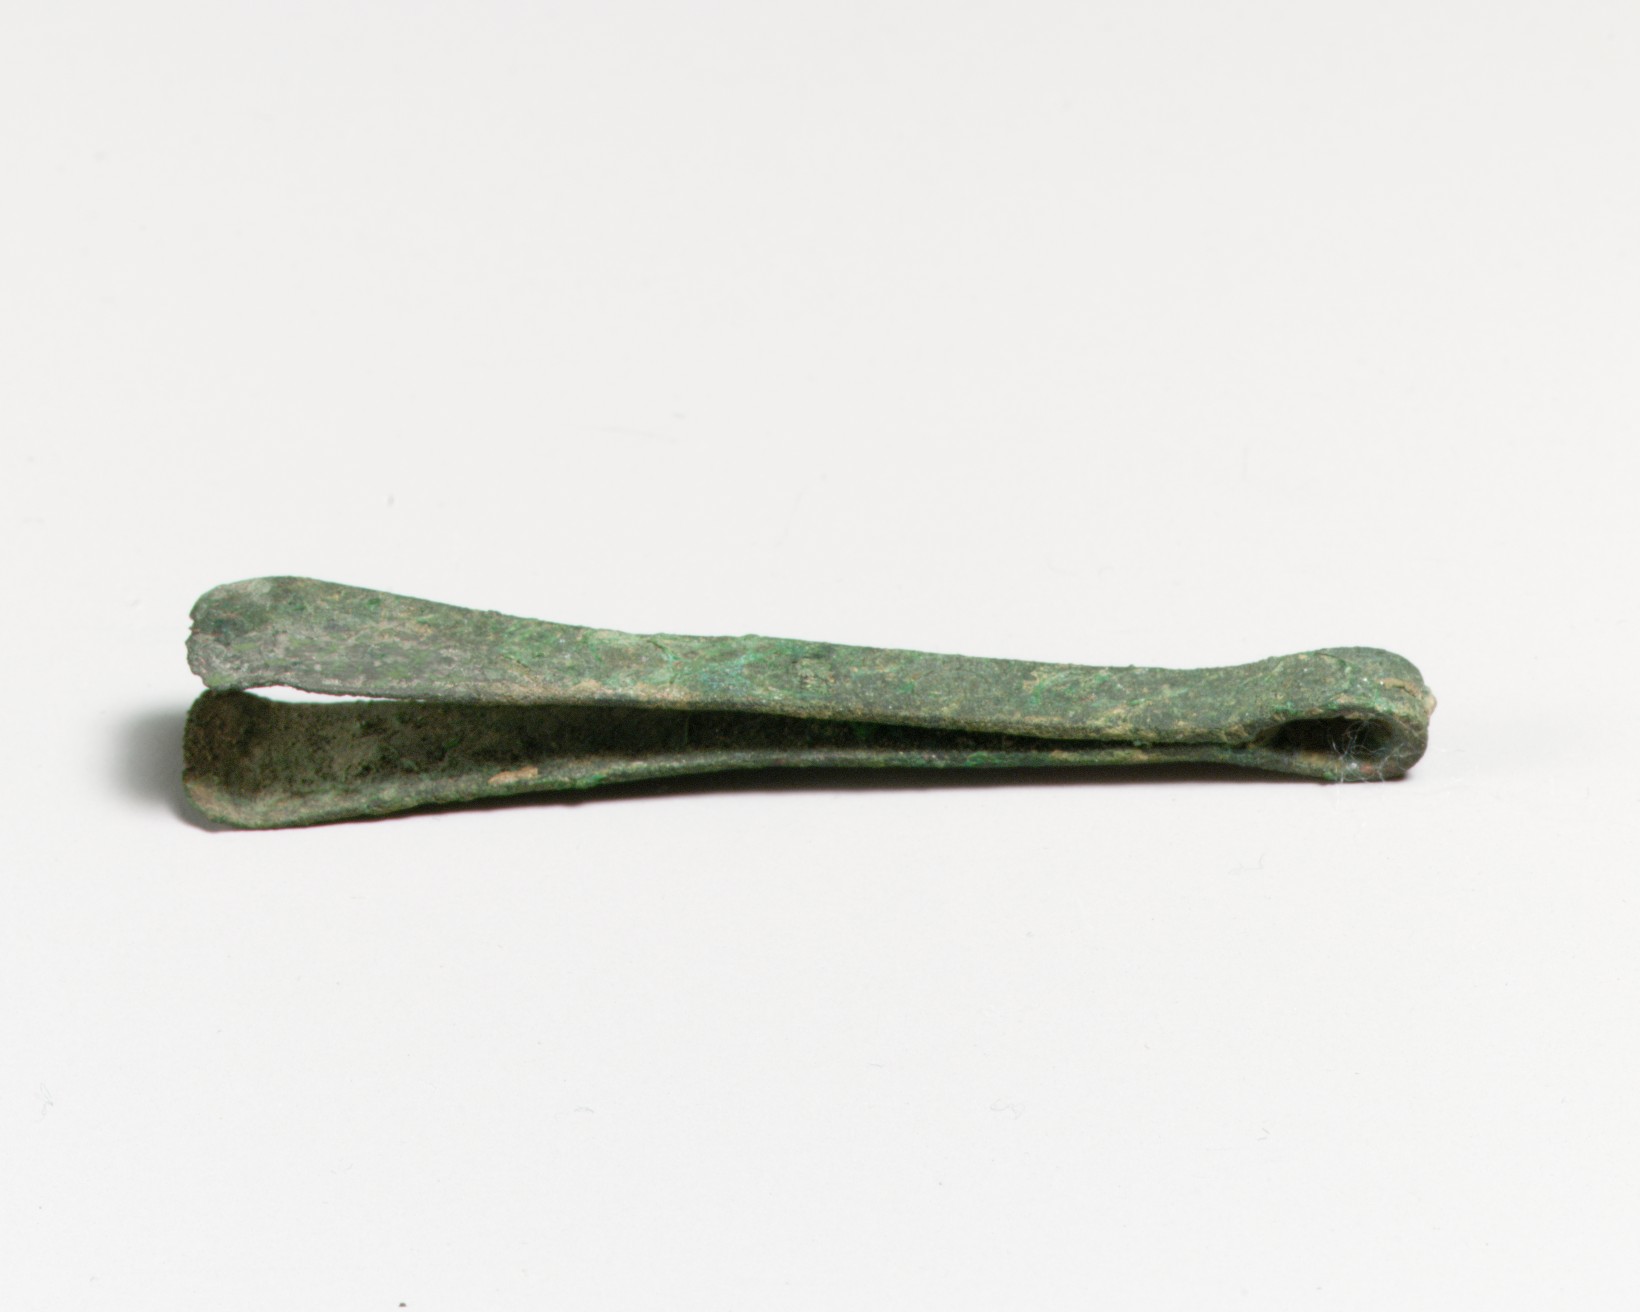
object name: tweezer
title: Tweezers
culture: cypriot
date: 3200-2000 BCE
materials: bronze